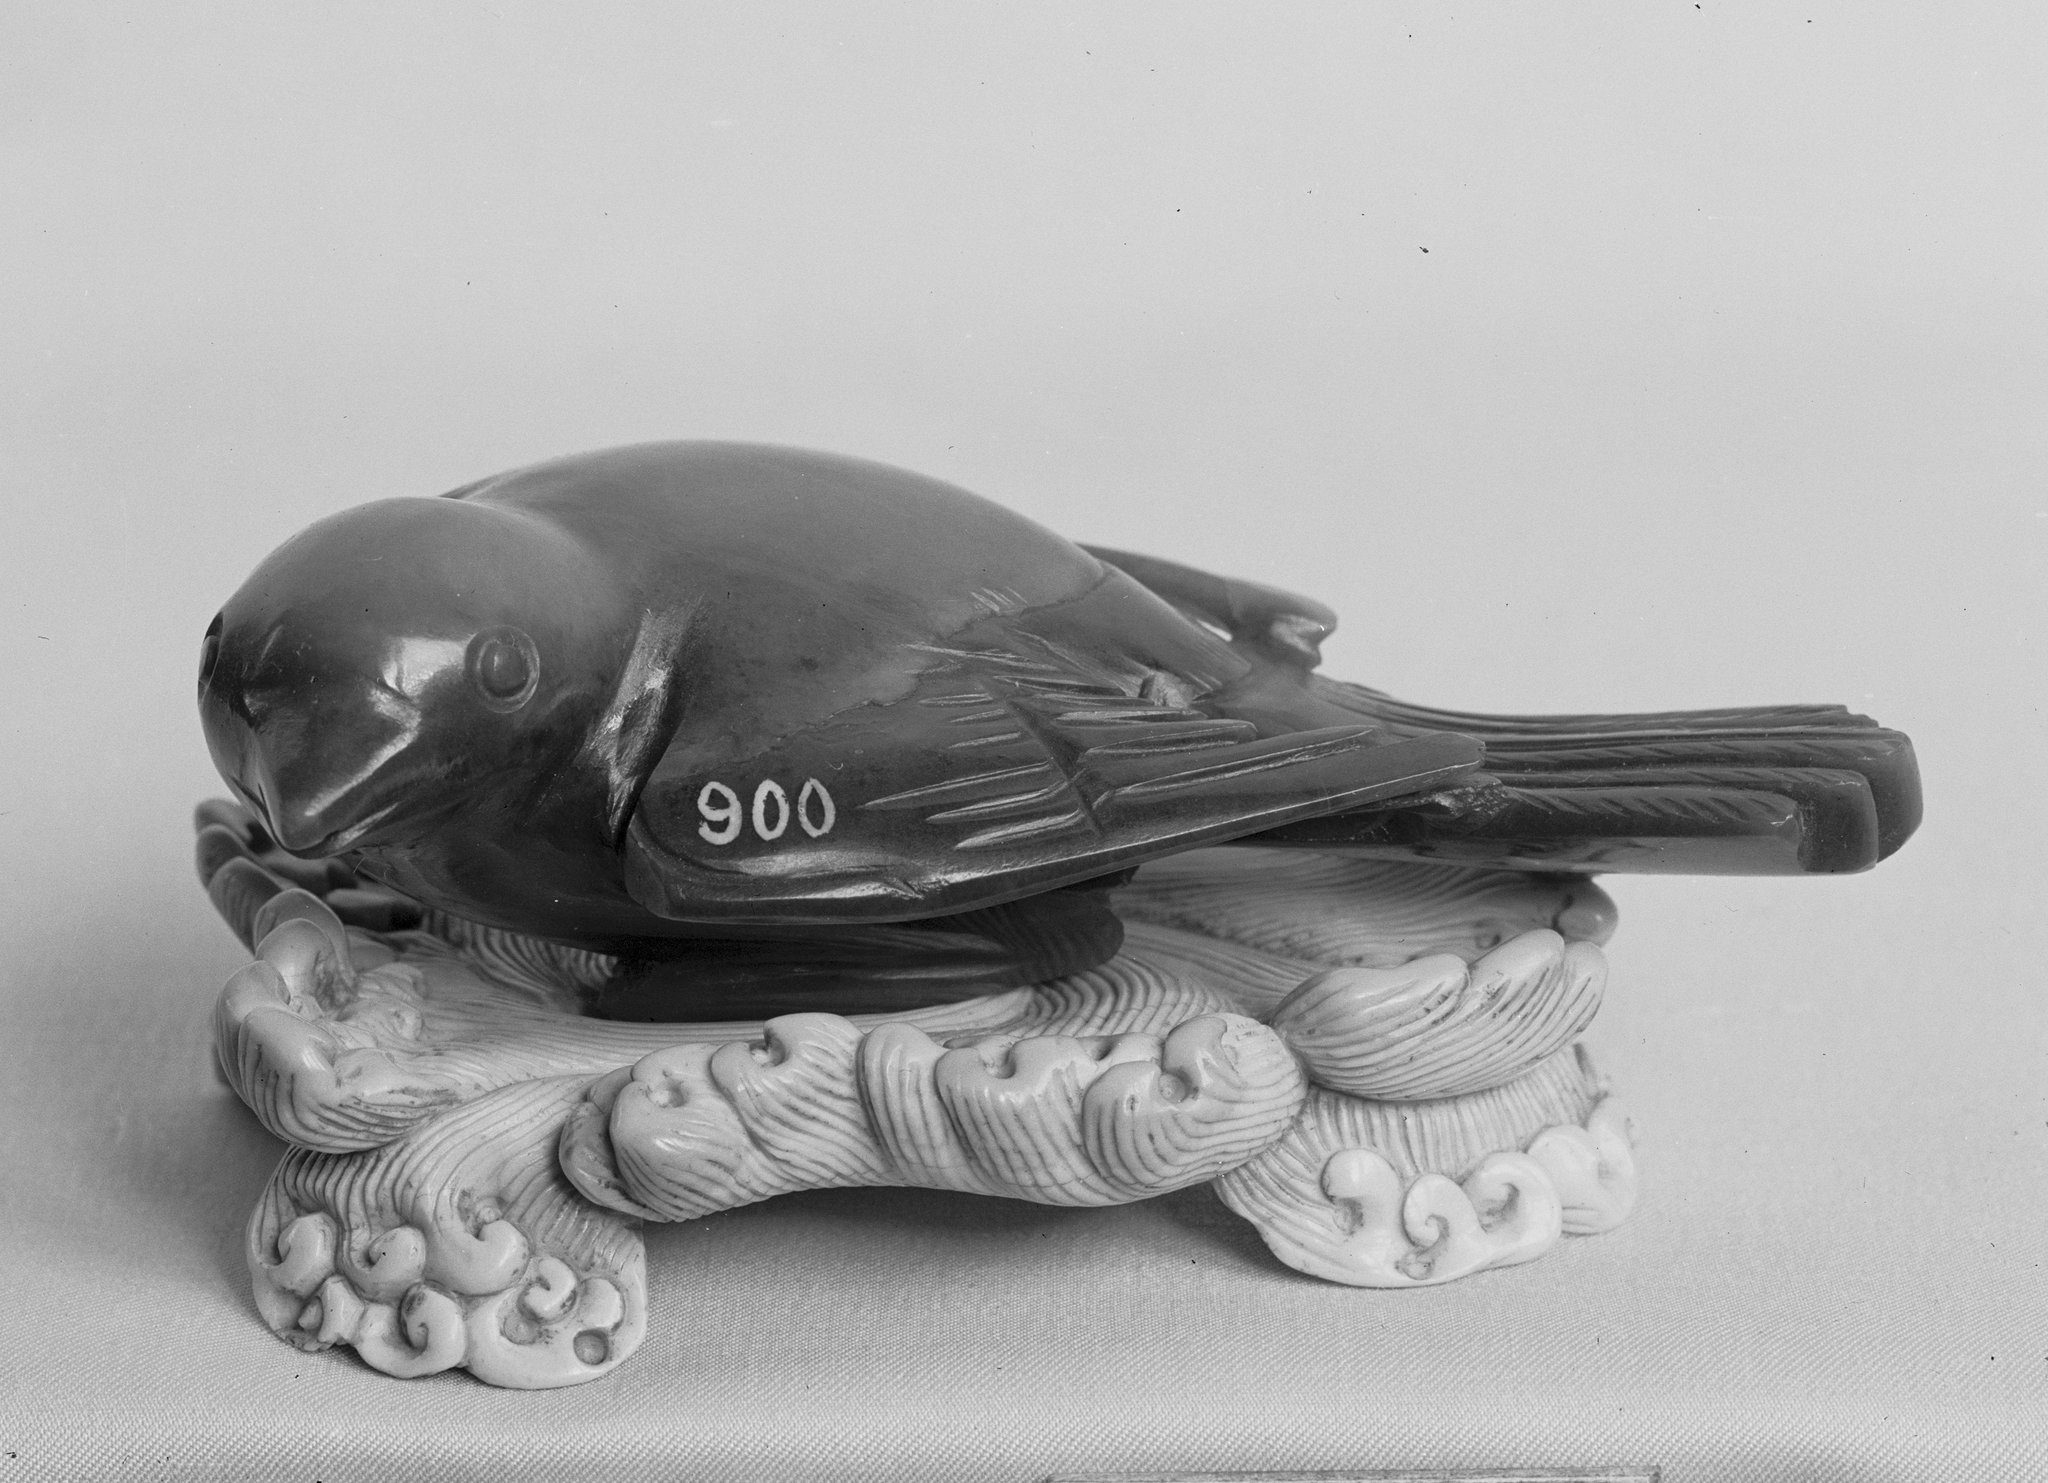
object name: figure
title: Figure of Swallow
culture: chinese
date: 1701-1800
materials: stone, ivory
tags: birds